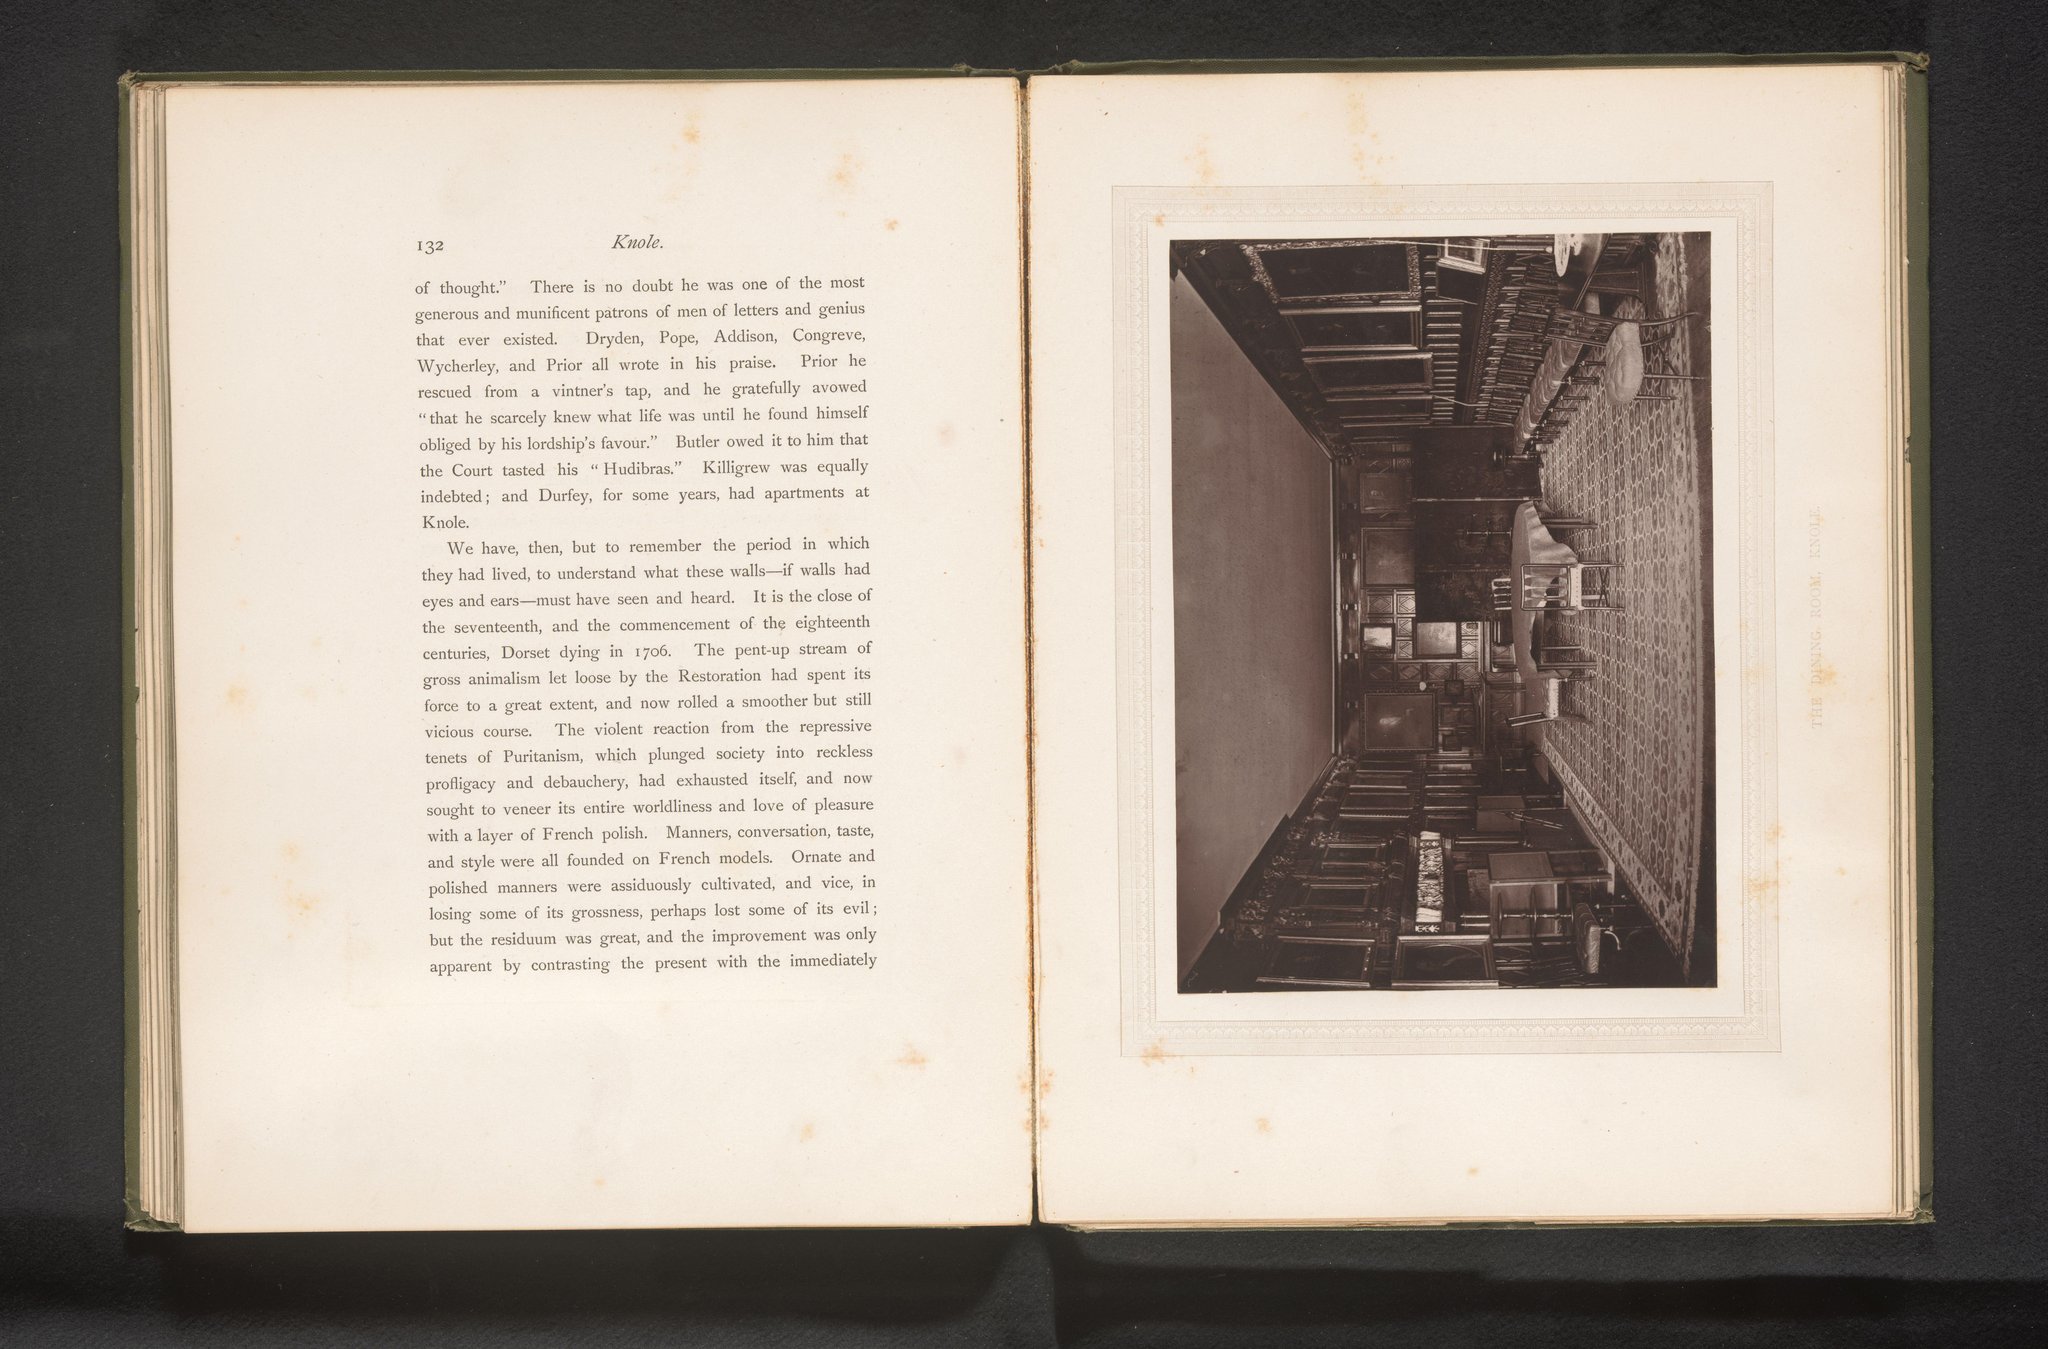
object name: photomechanical print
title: Interieur van de eetkamer van Knole House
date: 1866-1876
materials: paper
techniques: woodburytype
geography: knole house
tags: interior of the house, dining-room